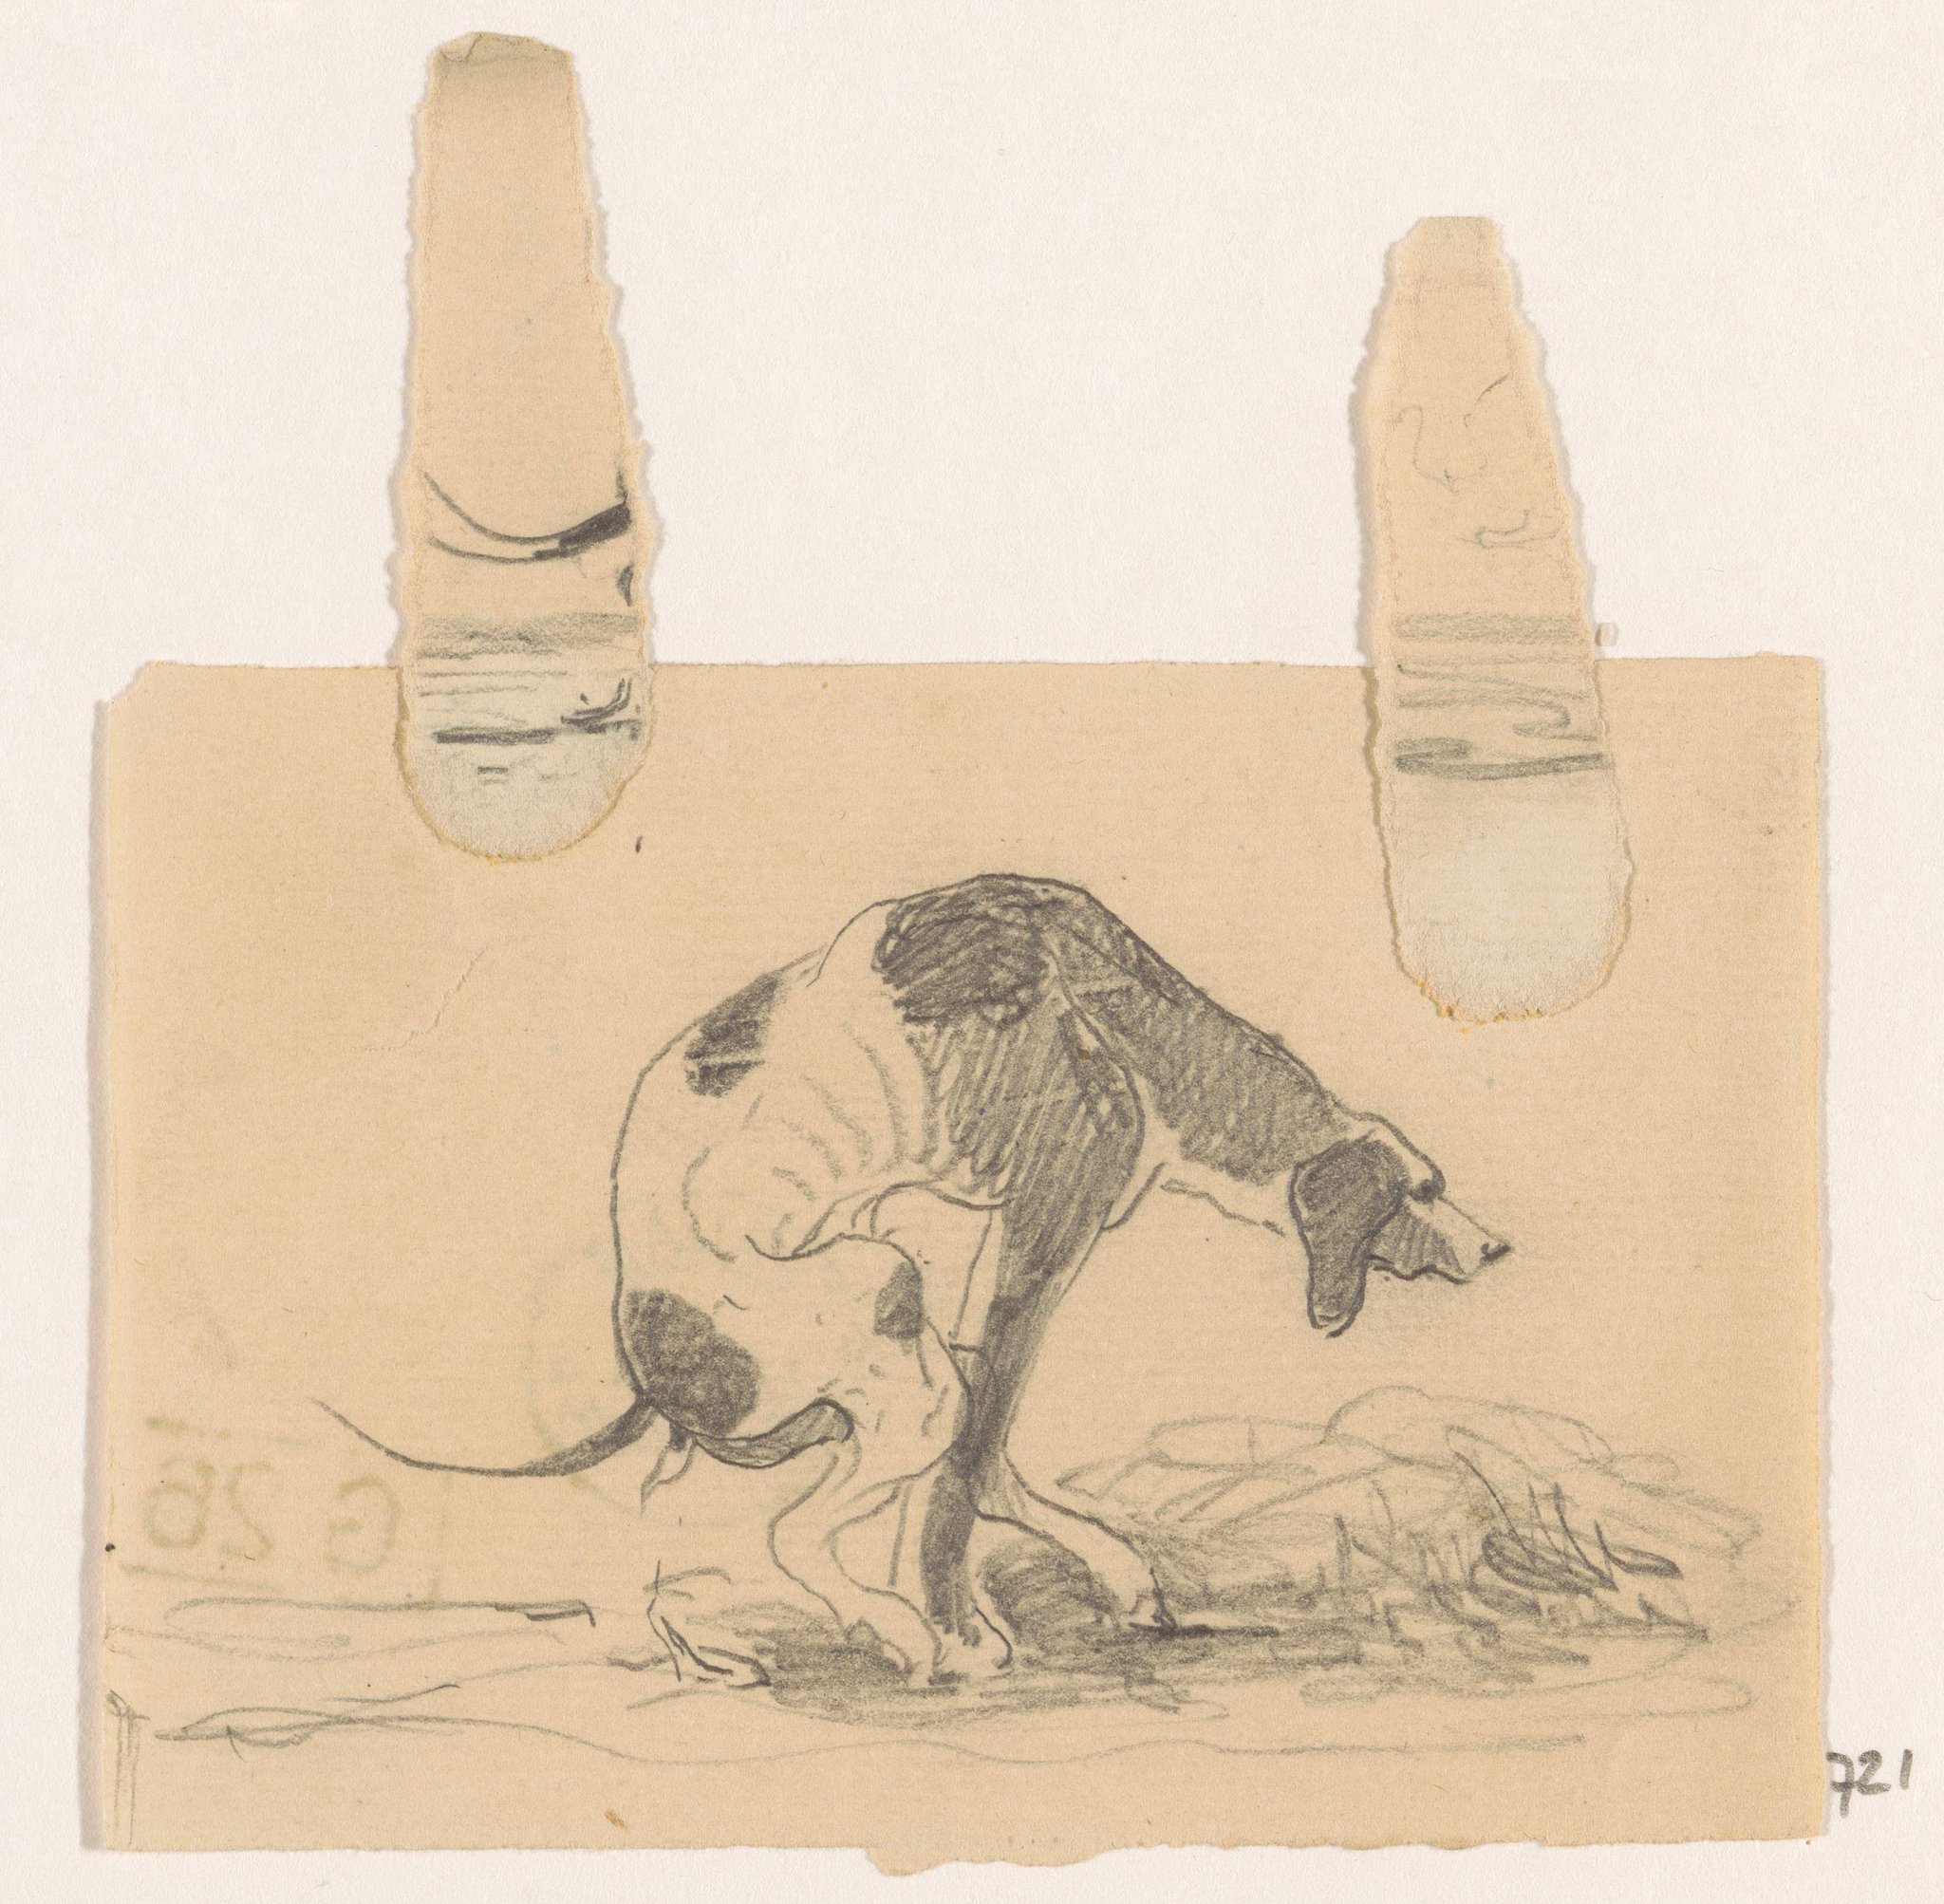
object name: drawing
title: Poepende hond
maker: johannes tavenraat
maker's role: draughtsman, painter, print maker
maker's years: 1809-1881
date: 1840-1880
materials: paper, pencil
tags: hunting dogs, fabulous animals ~ domestic animals (+ animal excreting), dog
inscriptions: collector's mark: Lugt 2228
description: Poepende hond. Getekend op de achterzijde van een deel van een envelop.